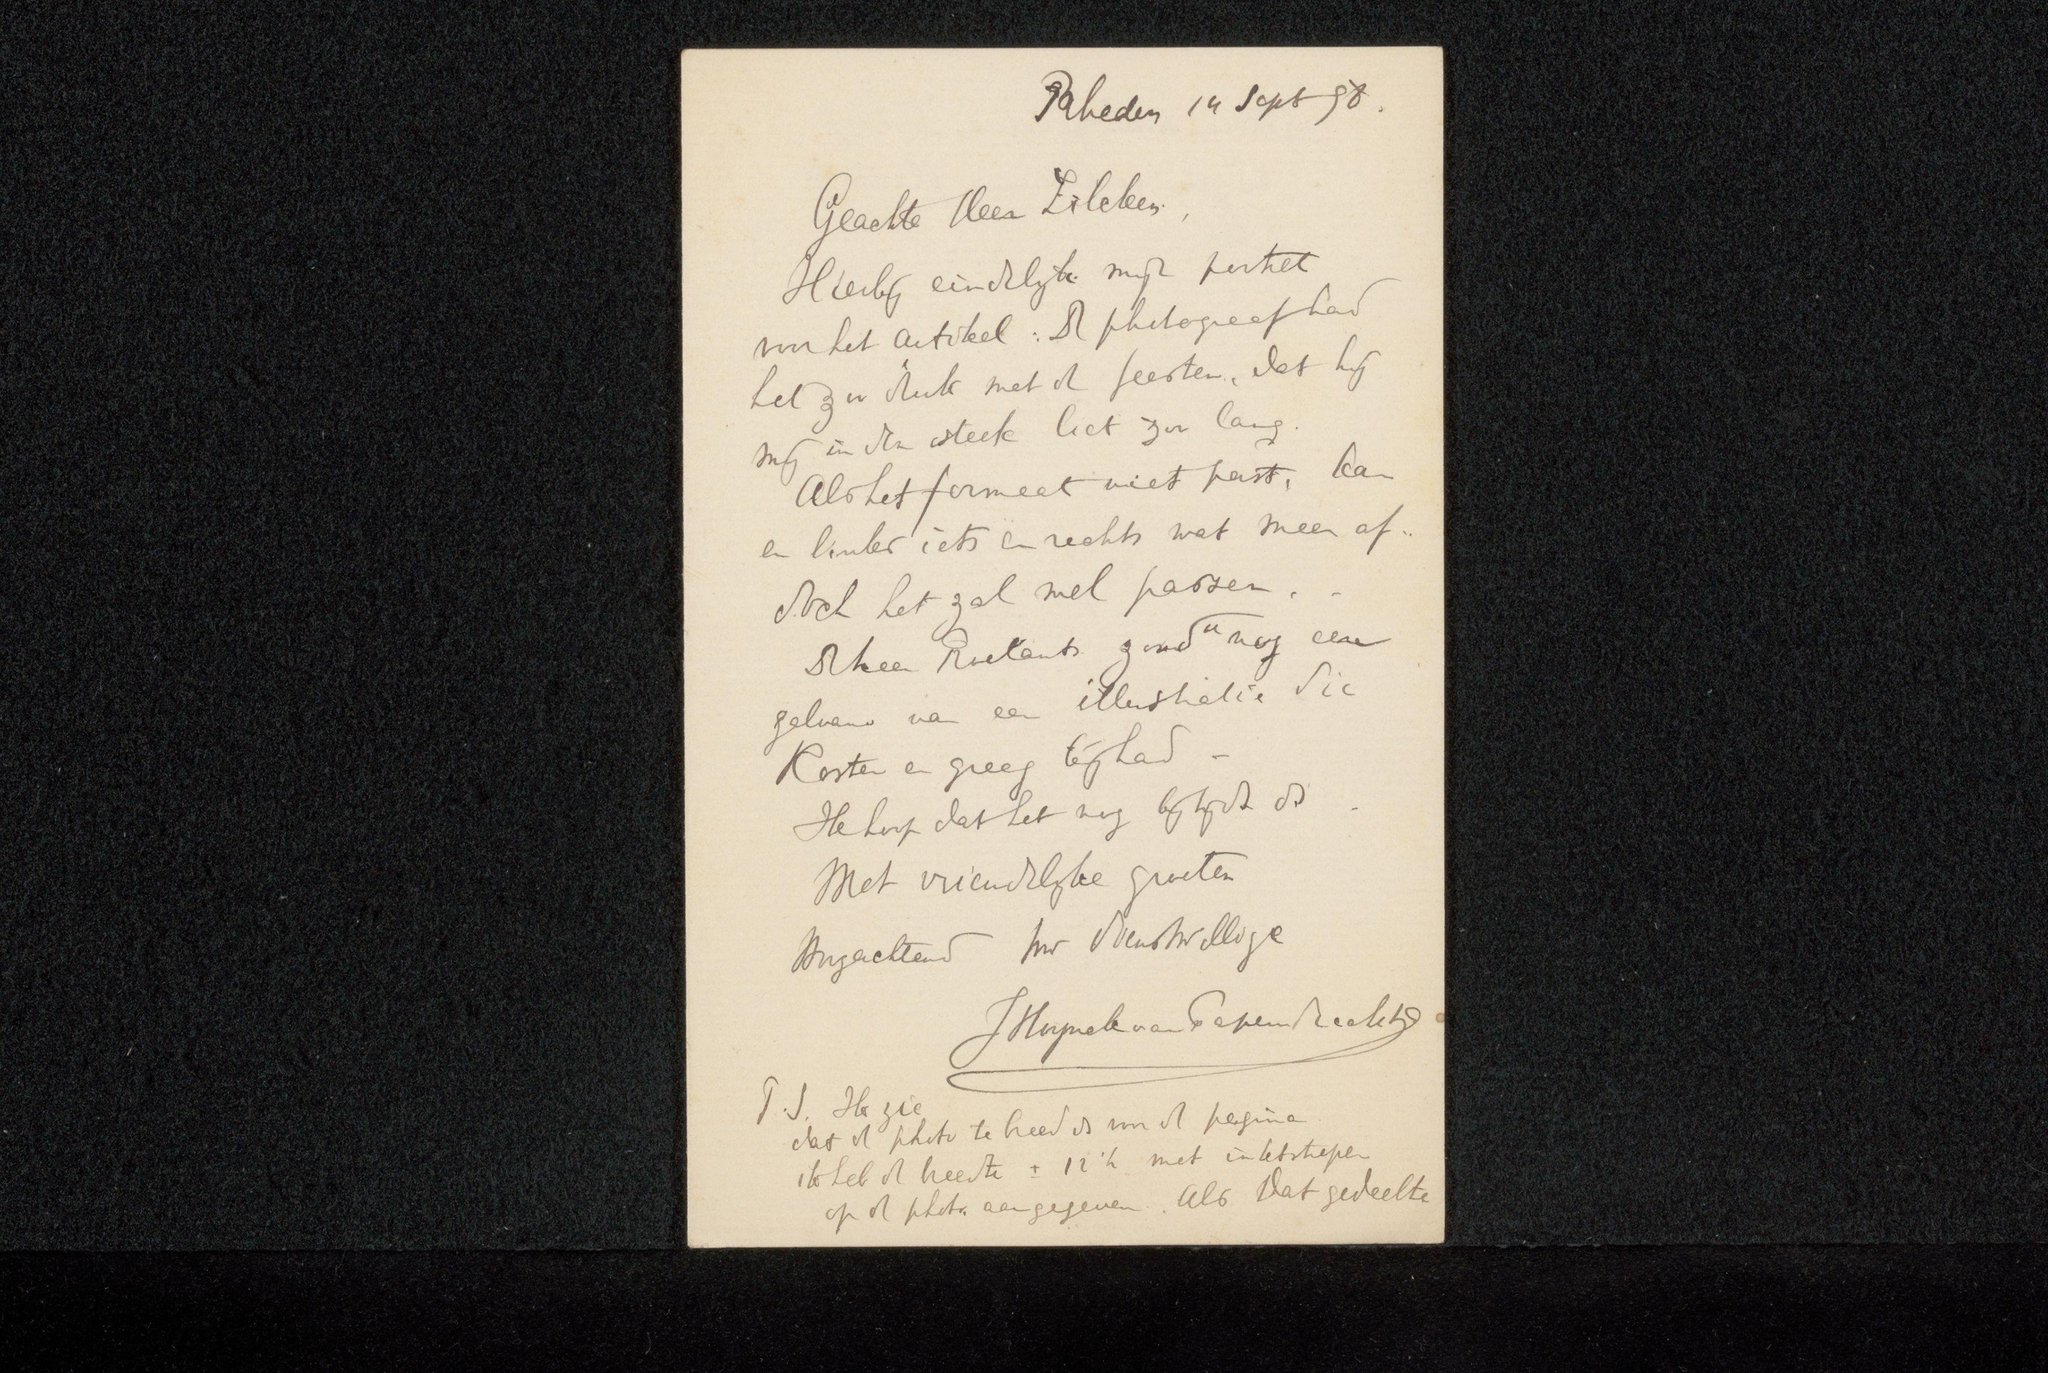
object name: letter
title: Brief aan Philip Zilcken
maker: jan hoynck van papendrecht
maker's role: draughtsman, painter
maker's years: 1858-1933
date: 1898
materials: ink, paper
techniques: pen, writing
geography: rheden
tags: amsterdam, the hague, painter, jan hoynck van papendrecht, philip zilcken, photography, cinematography, historical persons (portraits and scenes from the life)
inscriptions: collector's mark: ‘RPK’